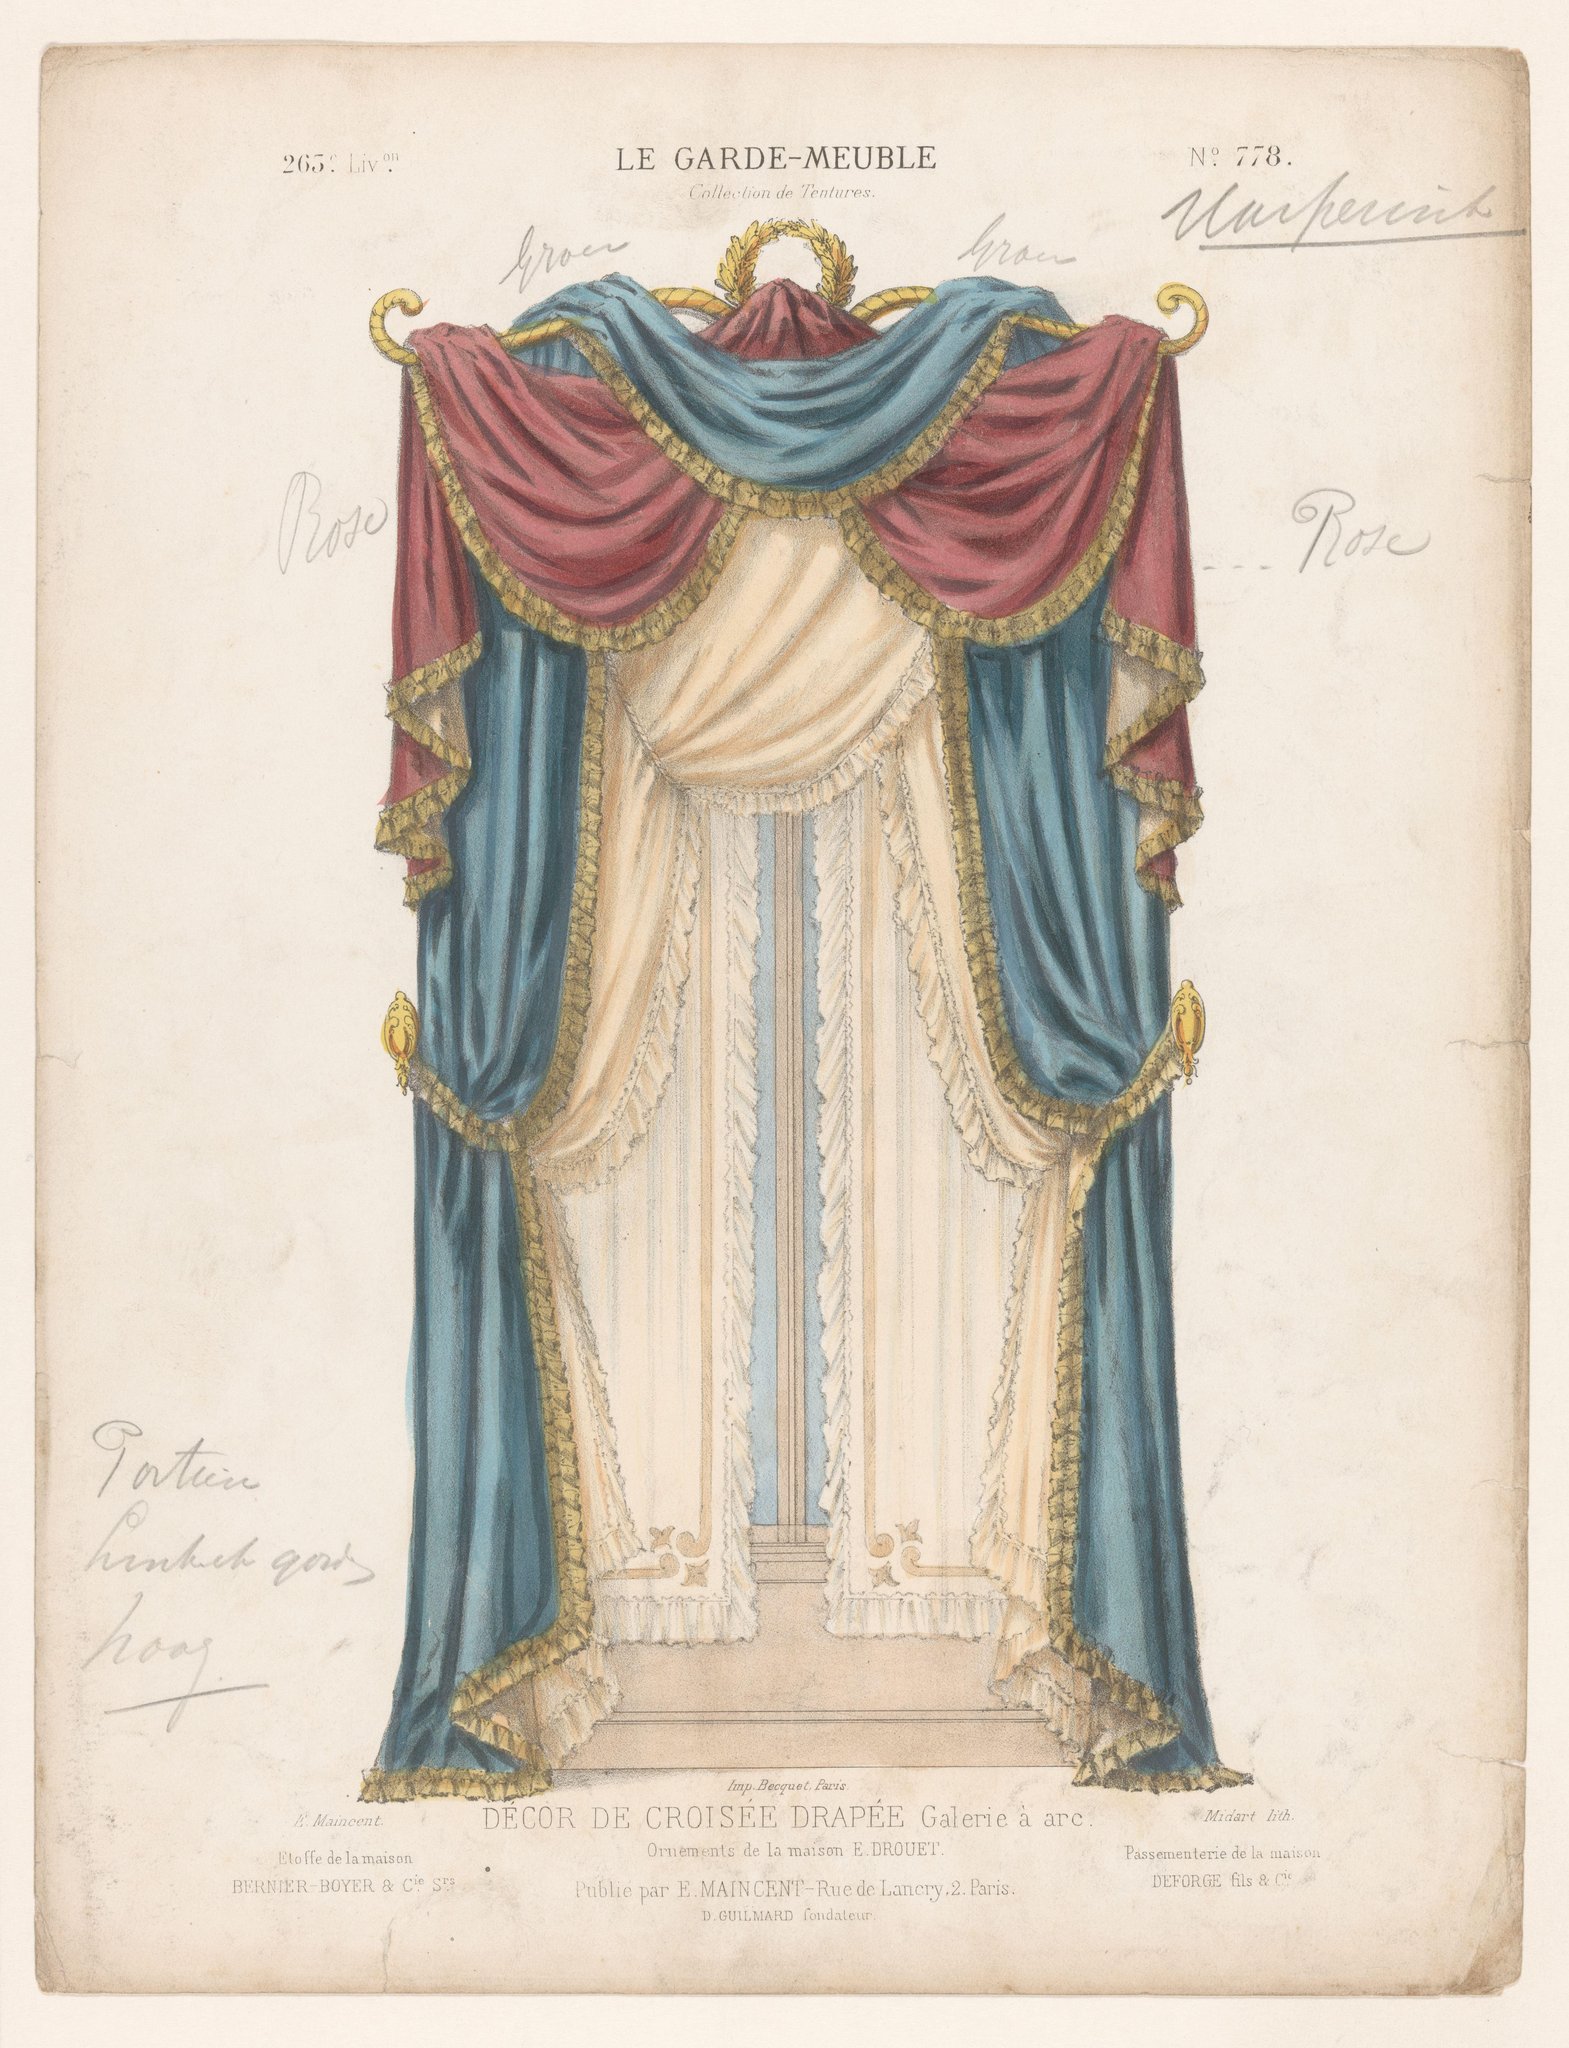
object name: print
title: Décor de Croisée drapée / Galerie à arc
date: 1885-1895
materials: paper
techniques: hand coloring, lithograph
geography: paris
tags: window, hangings and drapery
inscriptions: annotation: ‘Groen/ [...]/ Roze’, annotation: ‘Portière [...] hoog’, annotation: ‘Groen/ Roze’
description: Kruisvenster met gedrapeerde gordijnen. Prent uit 263e Livraison.